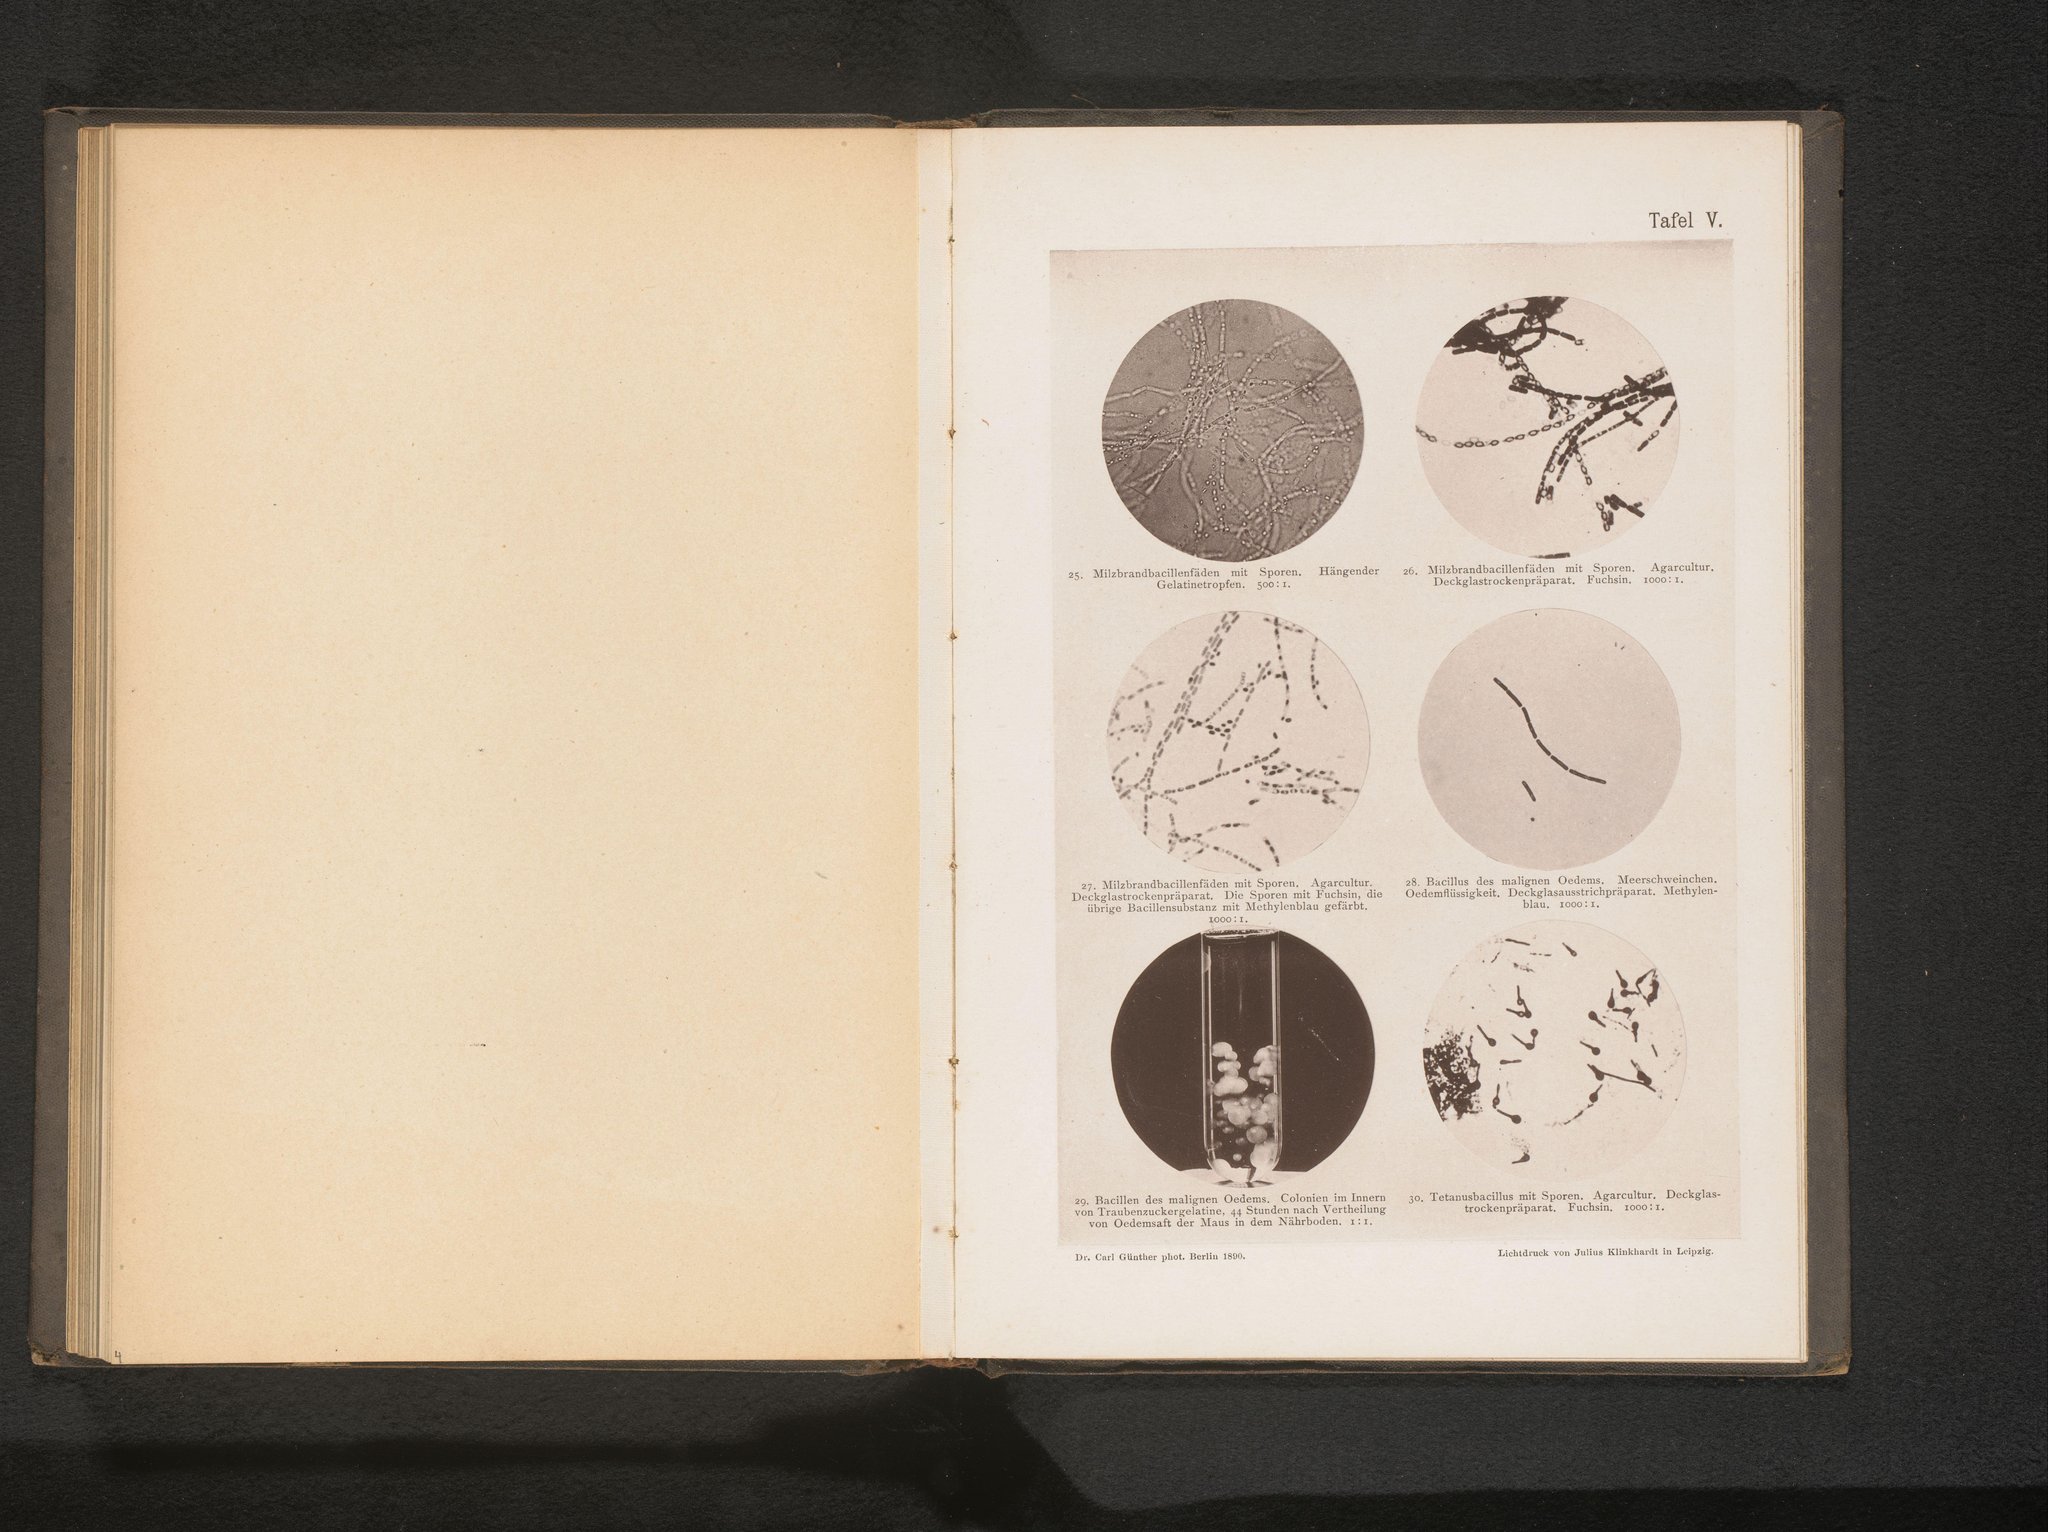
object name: photomechanical print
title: Zes microscoopopnamen van bacteriën, waaronder de miltvuurbacterie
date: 1880-1890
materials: paper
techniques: photograph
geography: leipzig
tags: unicellular animals, bacteria, bacilli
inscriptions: number: ‘Tafel V.’, inscription: ‘25. Milzbrandbacillenfäden mit Sporen. Hängender Gelatinetropfen. 500:1. 26. Milzbrandbacillenfäden mit Sporen. Agarcultur. Deckglastrockenpräparat. Fuchsin. 1000:1. 27. Milzbrandbacillenfäden mit Sporen. Agarcultur. Deckglastrockenpräparat. Die Sporen mit Fuchsin, die übrige Bacillensubstanz mit Methylenblau gefärbt. 1000:1. 28. Bacillus des maligen Oedems. Meerschweinden. Oedemflüssigkeit. Deckglasausstrichpräparat. Methylenblau. 1000:1. 29. Bacillen des maligen Oedems. Colonien im Innern von Traubenzuckergelatine, 44 Stunden nach Vertheilung von Oedemsaft der Maus in dem Nährboden. 1:1. 30. Tetanusbacillus mit Sporen. Agarcultur. Deckglastrockenpräparat. Fuchsin. 1000:1..’